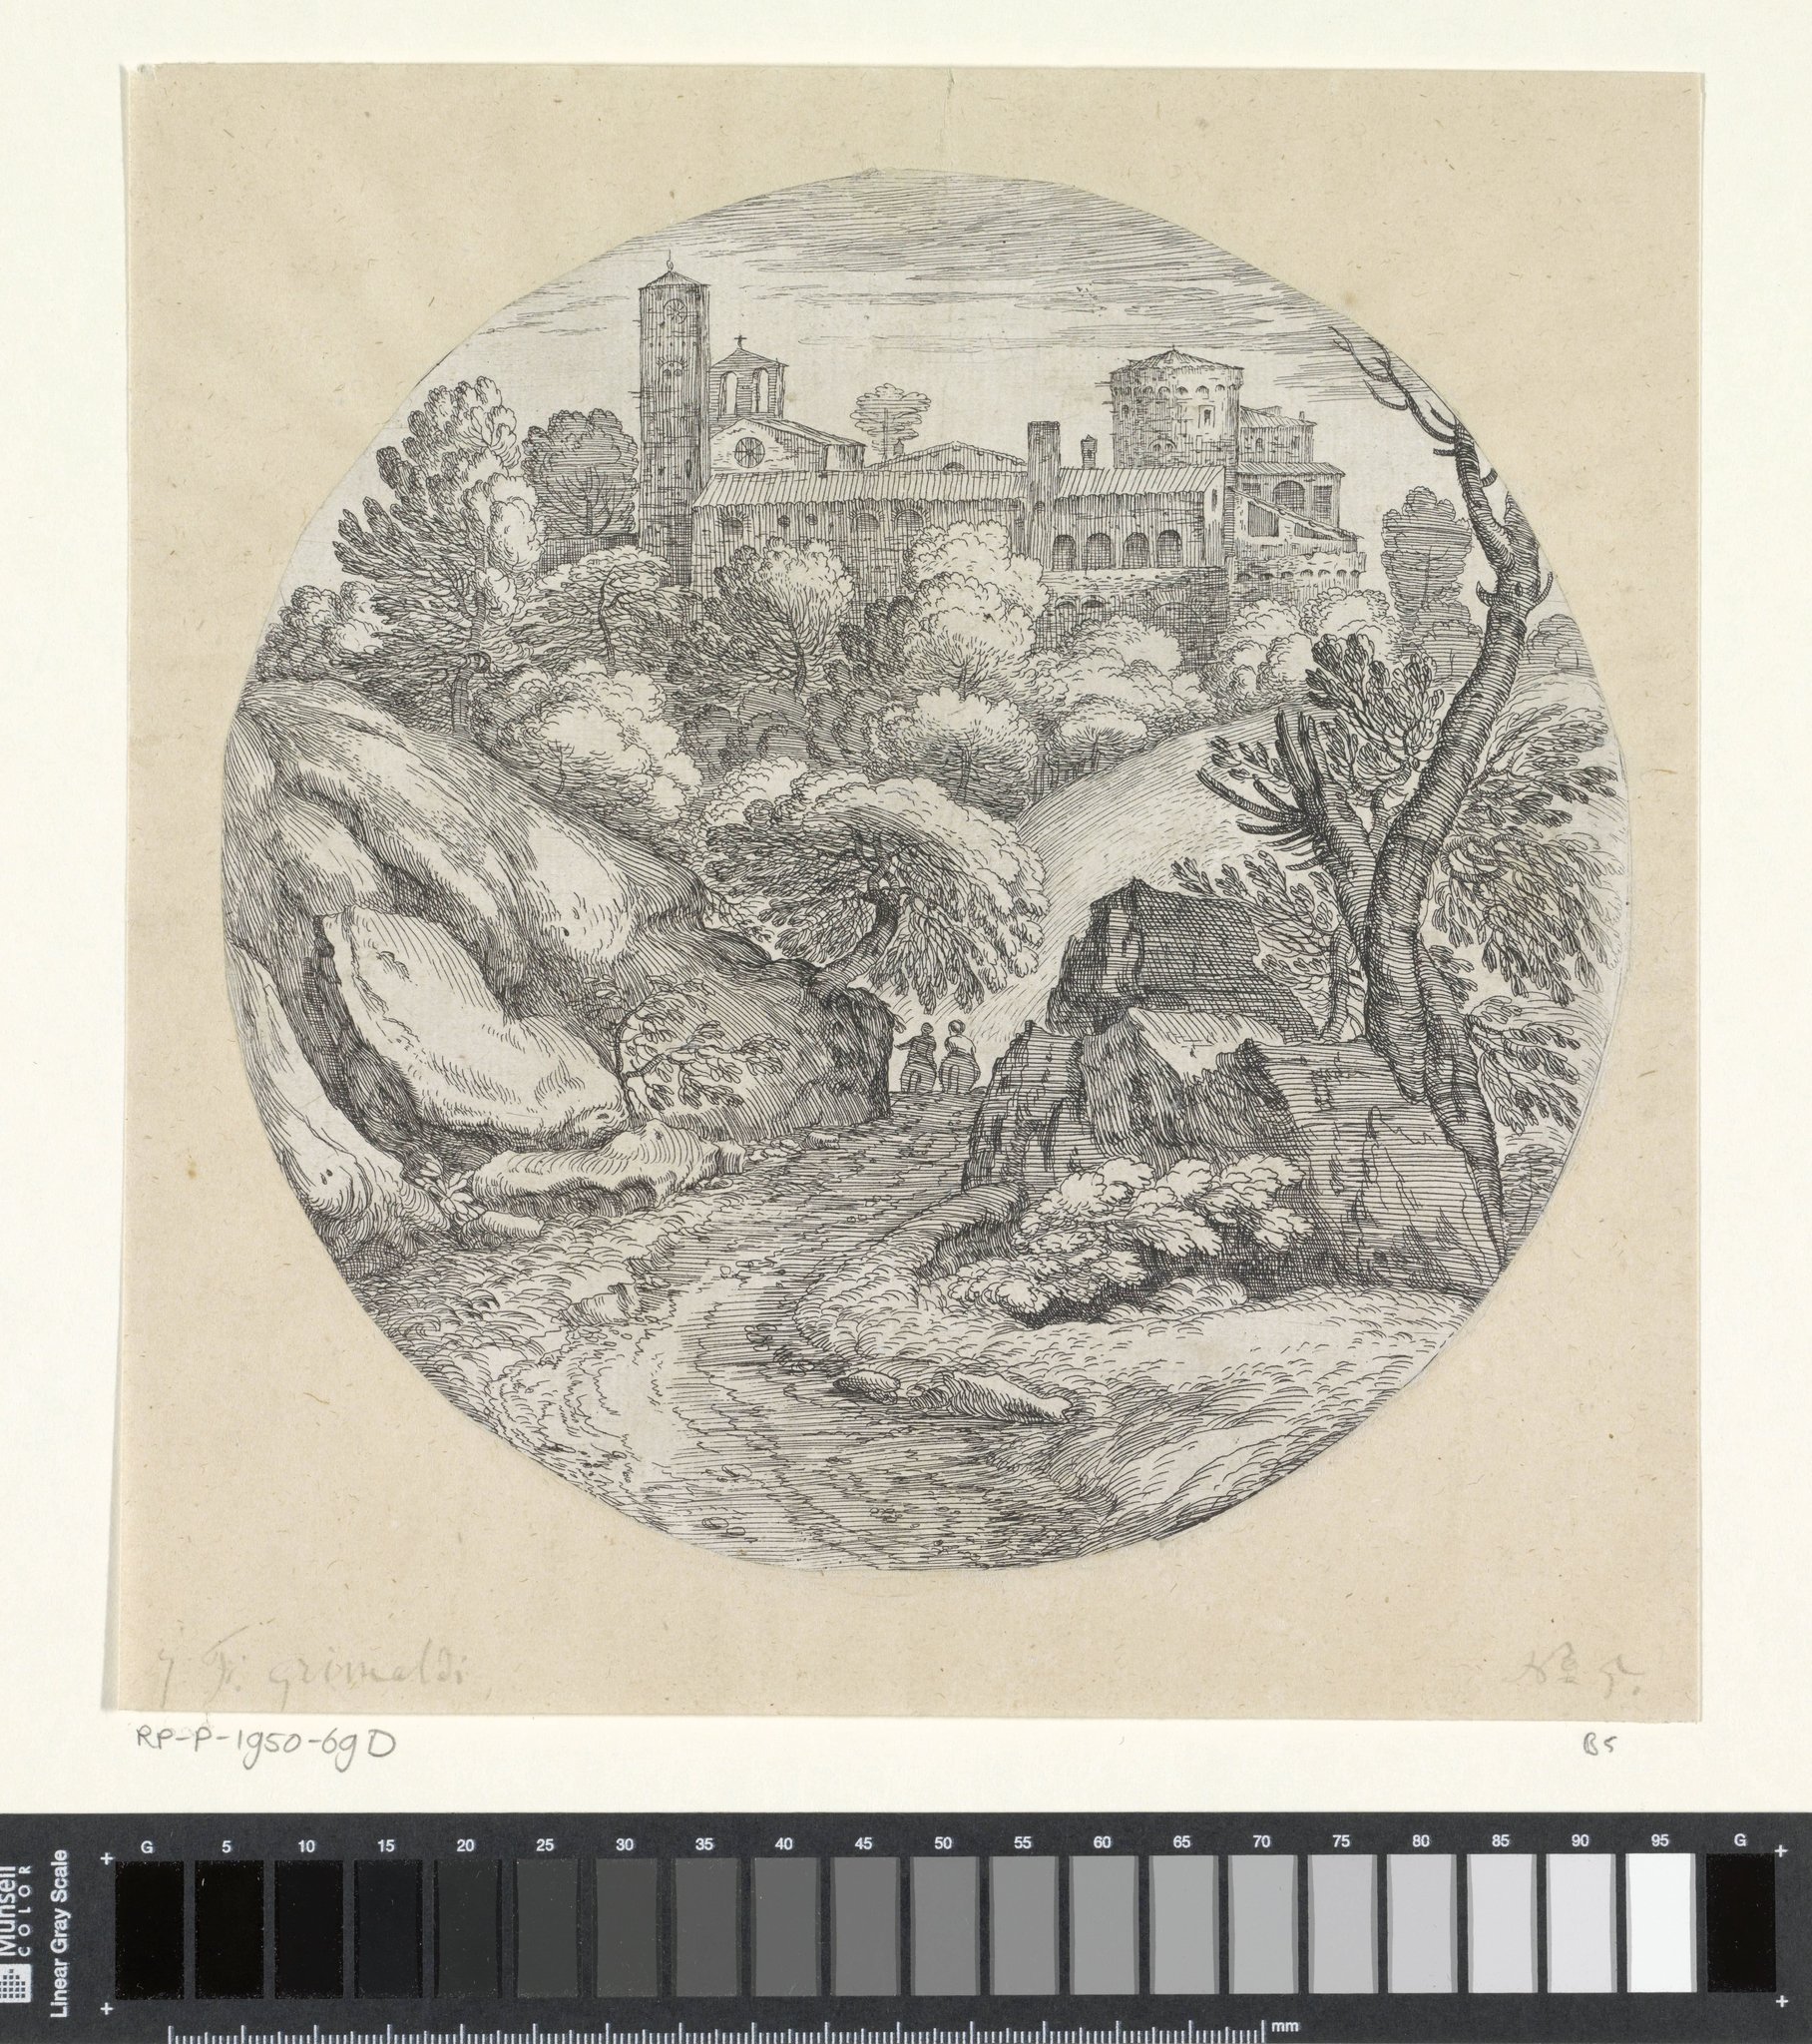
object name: print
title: Landschap met twee ruiters en een kasteel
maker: giovanni francesco grimaldi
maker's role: draughtsman, print maker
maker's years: 1606-1680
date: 1616-1680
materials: paper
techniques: etching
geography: italy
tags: riding a horse, ass, or mule; rider, horseman, city-view, and landscape with man-made constructions, landscapes, castle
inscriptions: collector's mark: Lugt 2228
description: Landschap met een kasteel op een heuvel. Twee ruiters te paard rijden over een weg richting het kasteel.